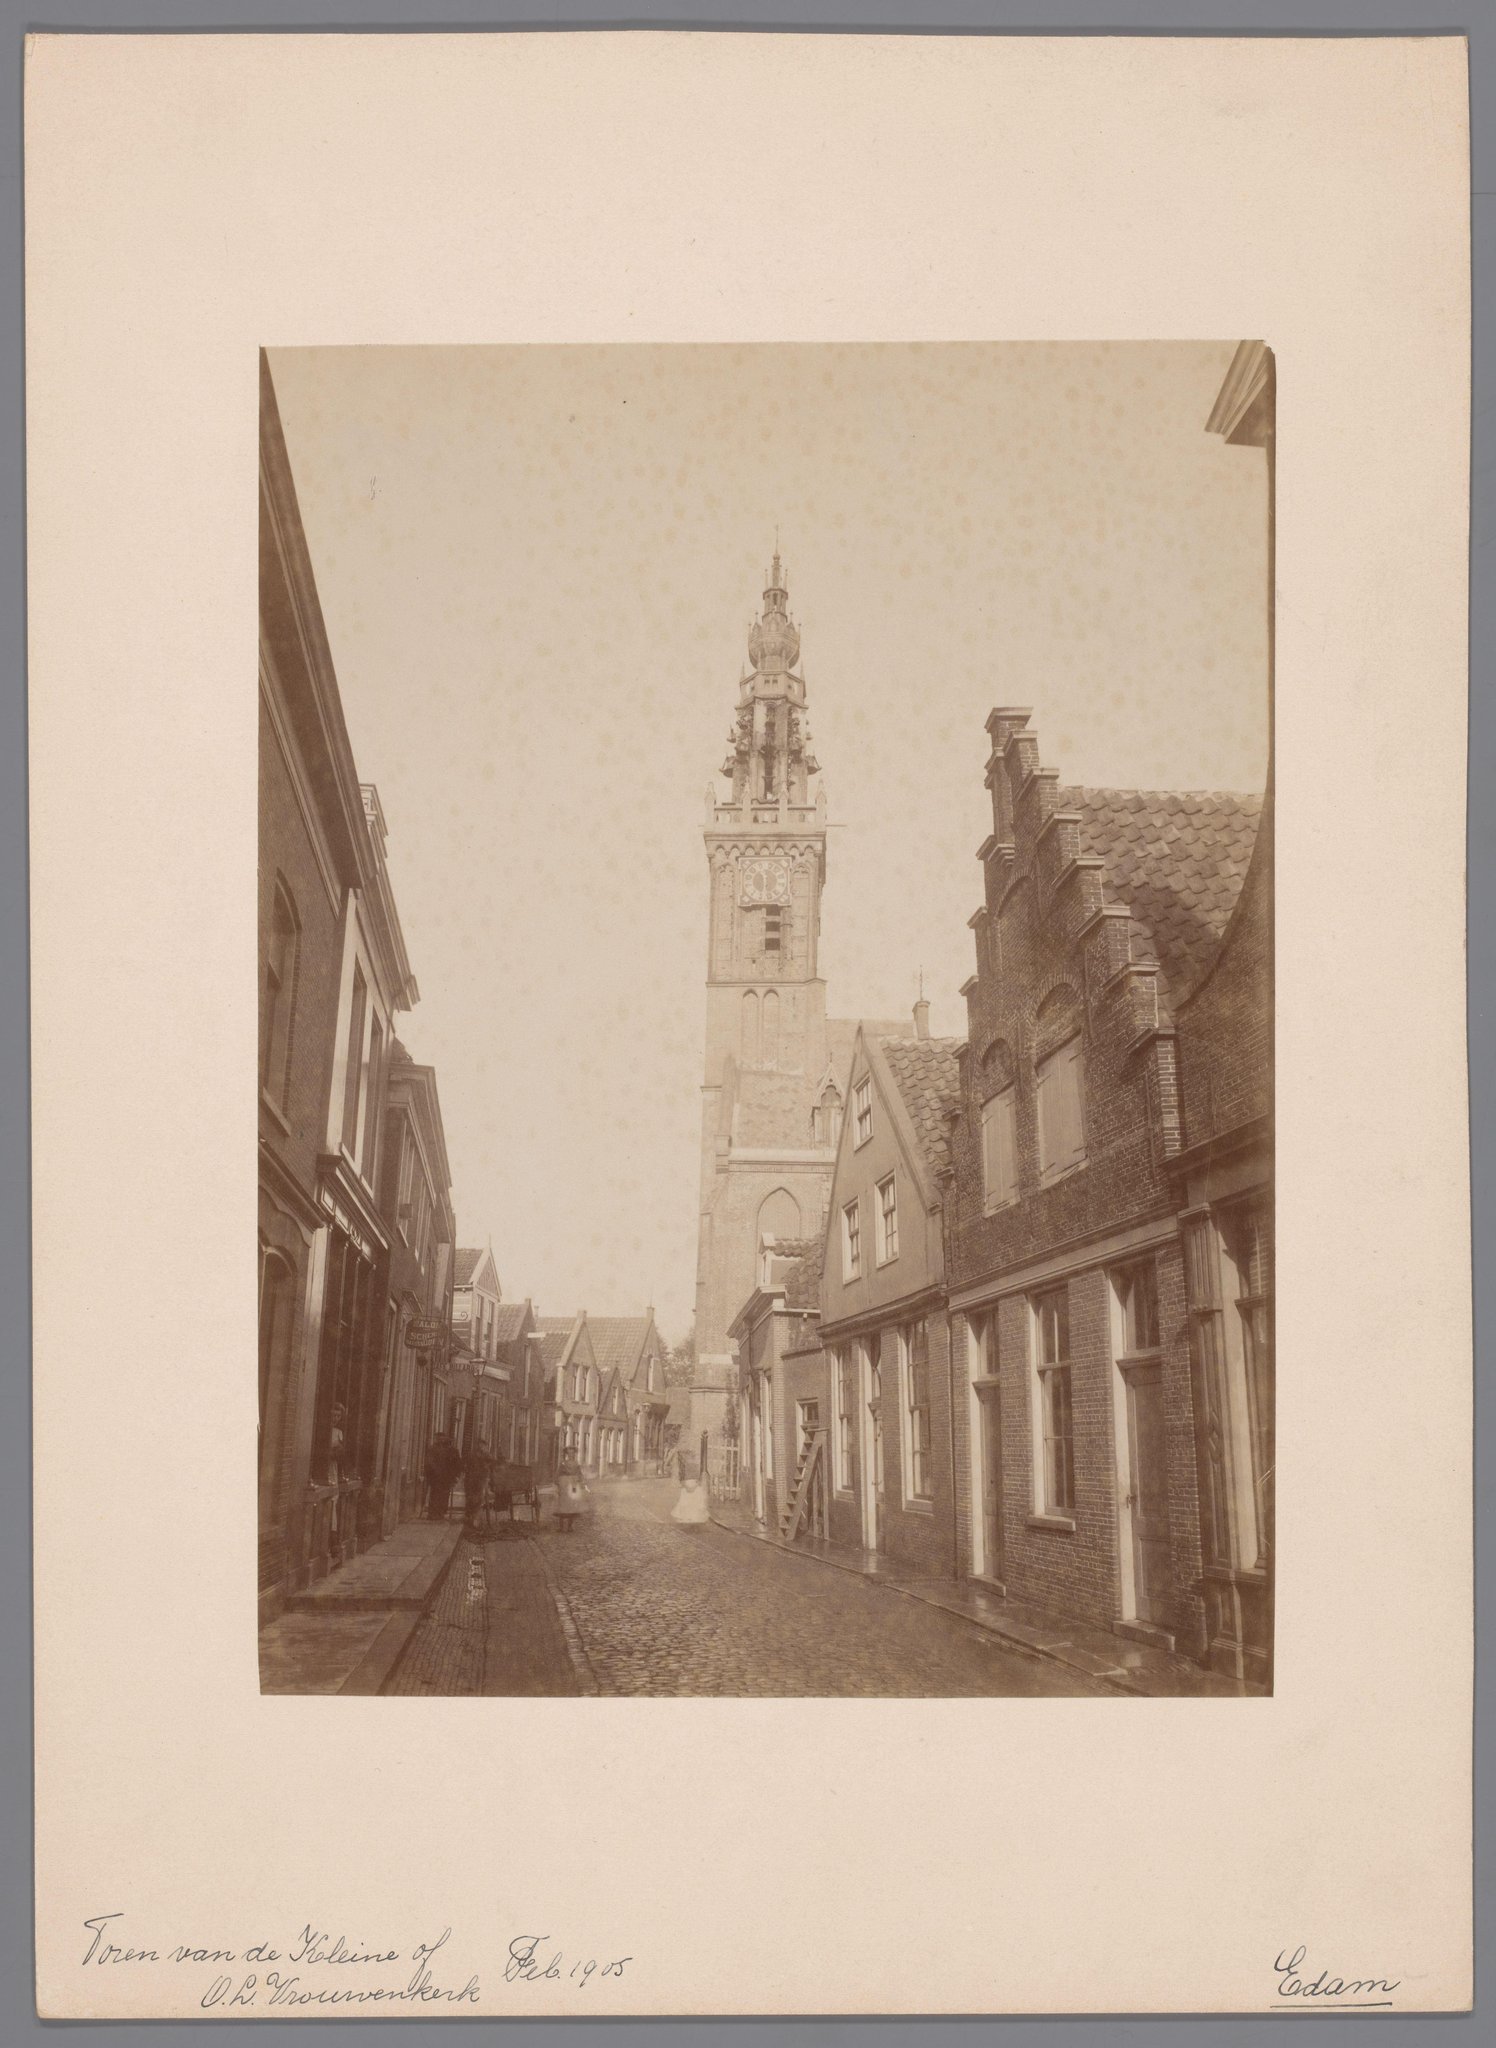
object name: photograph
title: Straatgezicht in Edam met de Kleine of Onze-Lieve-Vrouwekerk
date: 1905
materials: cardboard, photographic support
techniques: gelatin silver print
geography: edam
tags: church (exterior), street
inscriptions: annotation: ‘Edam (N.H.)/ Toren v/d kleine kerk/ oct 1905’, annotation: ‘Toren van de Kleine of O.L. Vrouwenkerk/ Feb 1905/ Edam’